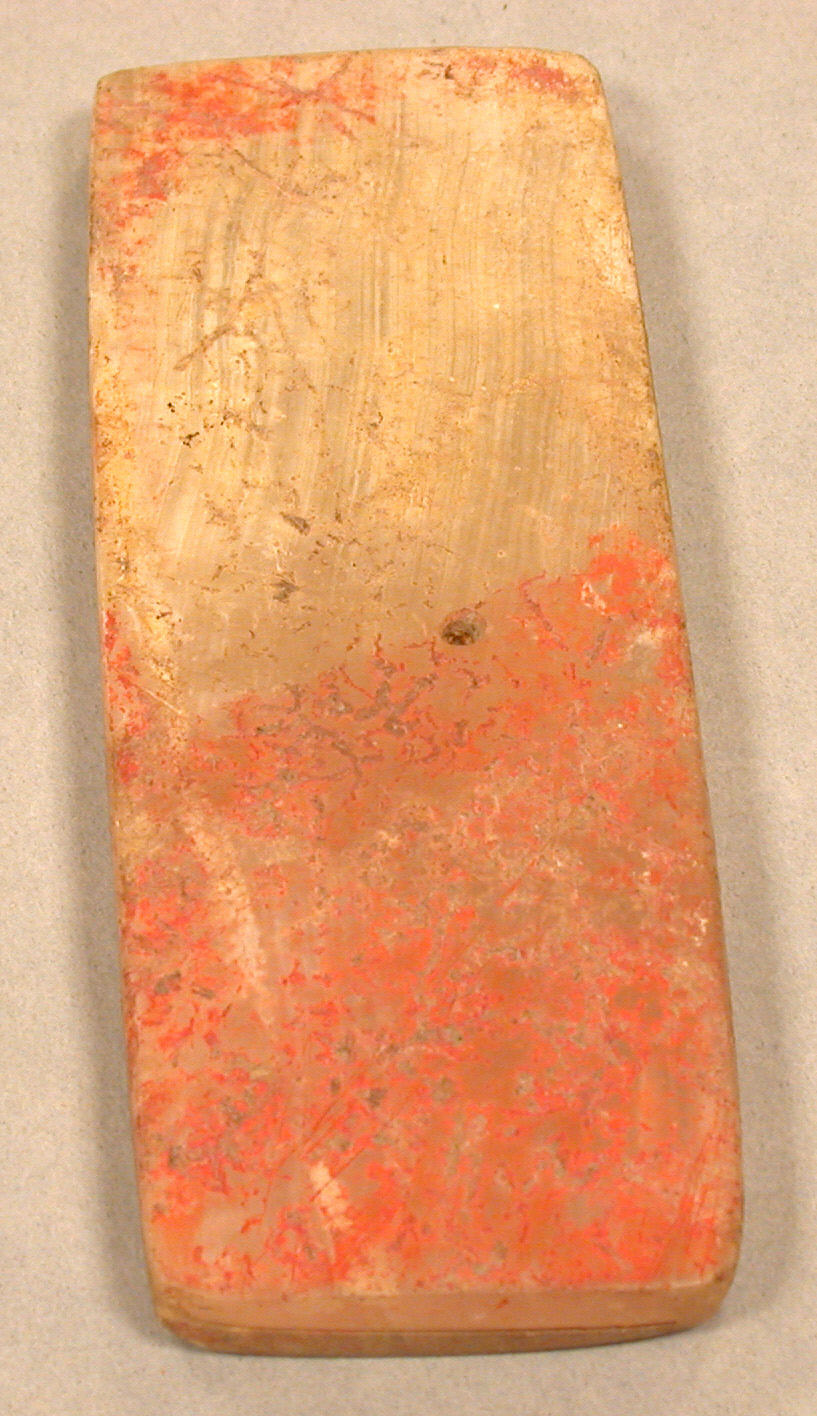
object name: musical instrument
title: Stone Musical Instrument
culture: mexican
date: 1501-1600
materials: pigment, stone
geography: mexico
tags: musical instruments